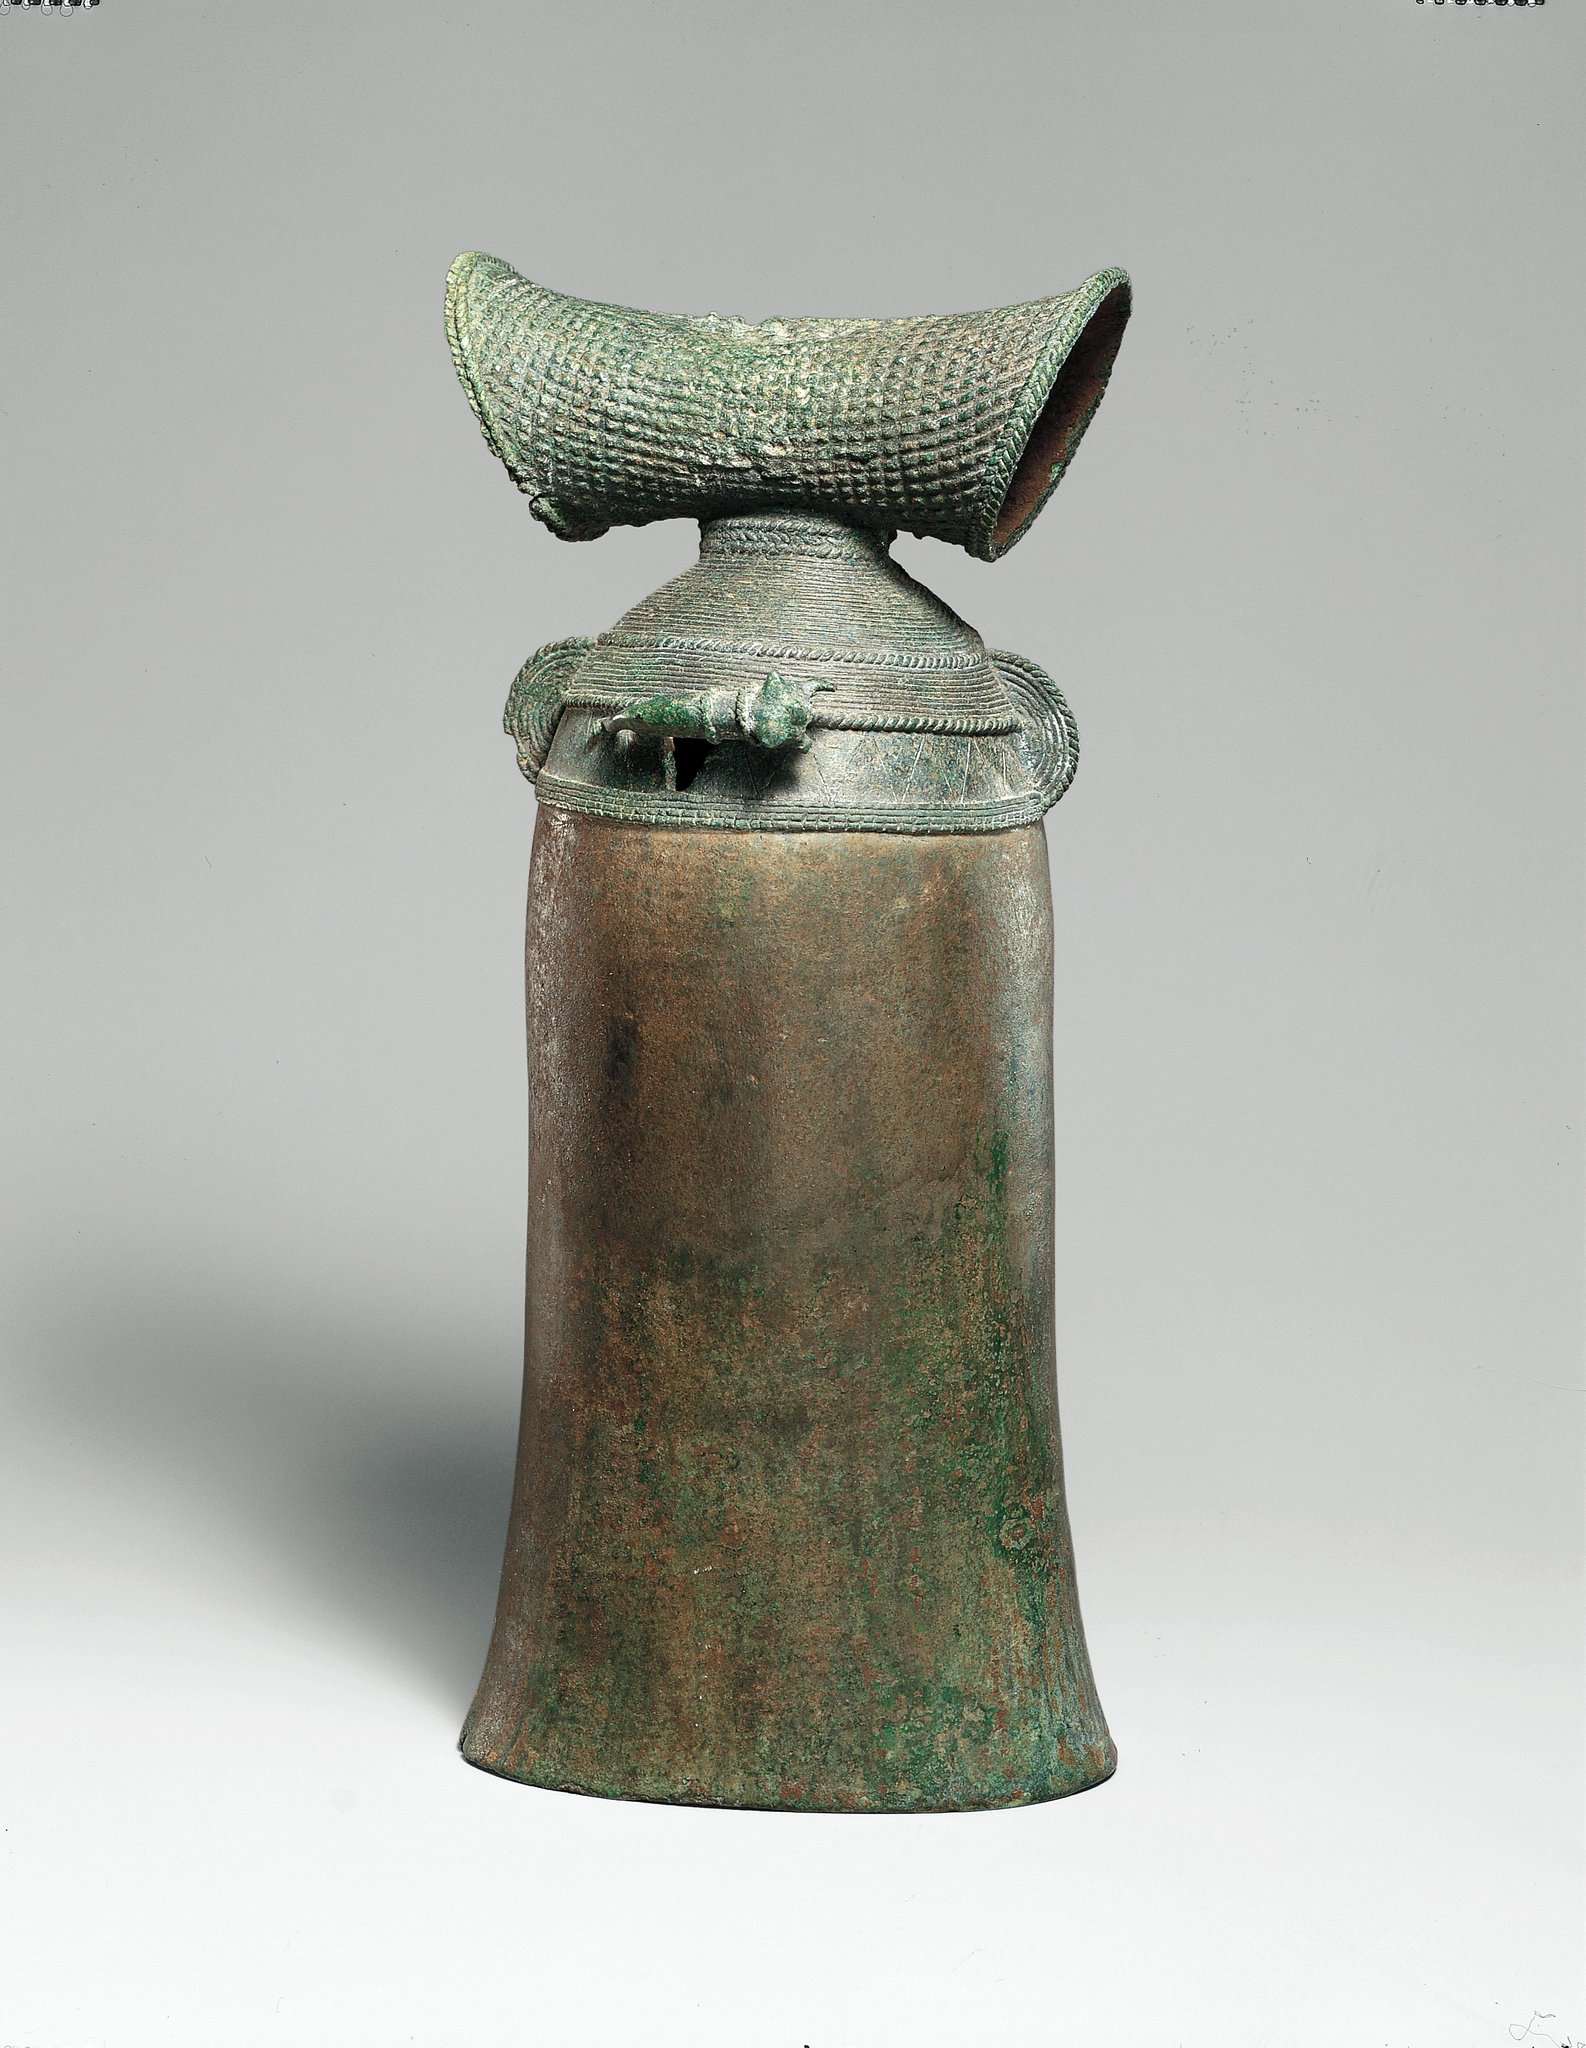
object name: bell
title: Elephant Bell with Miniature Elephant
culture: thai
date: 300 BCE-200 CE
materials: bronze